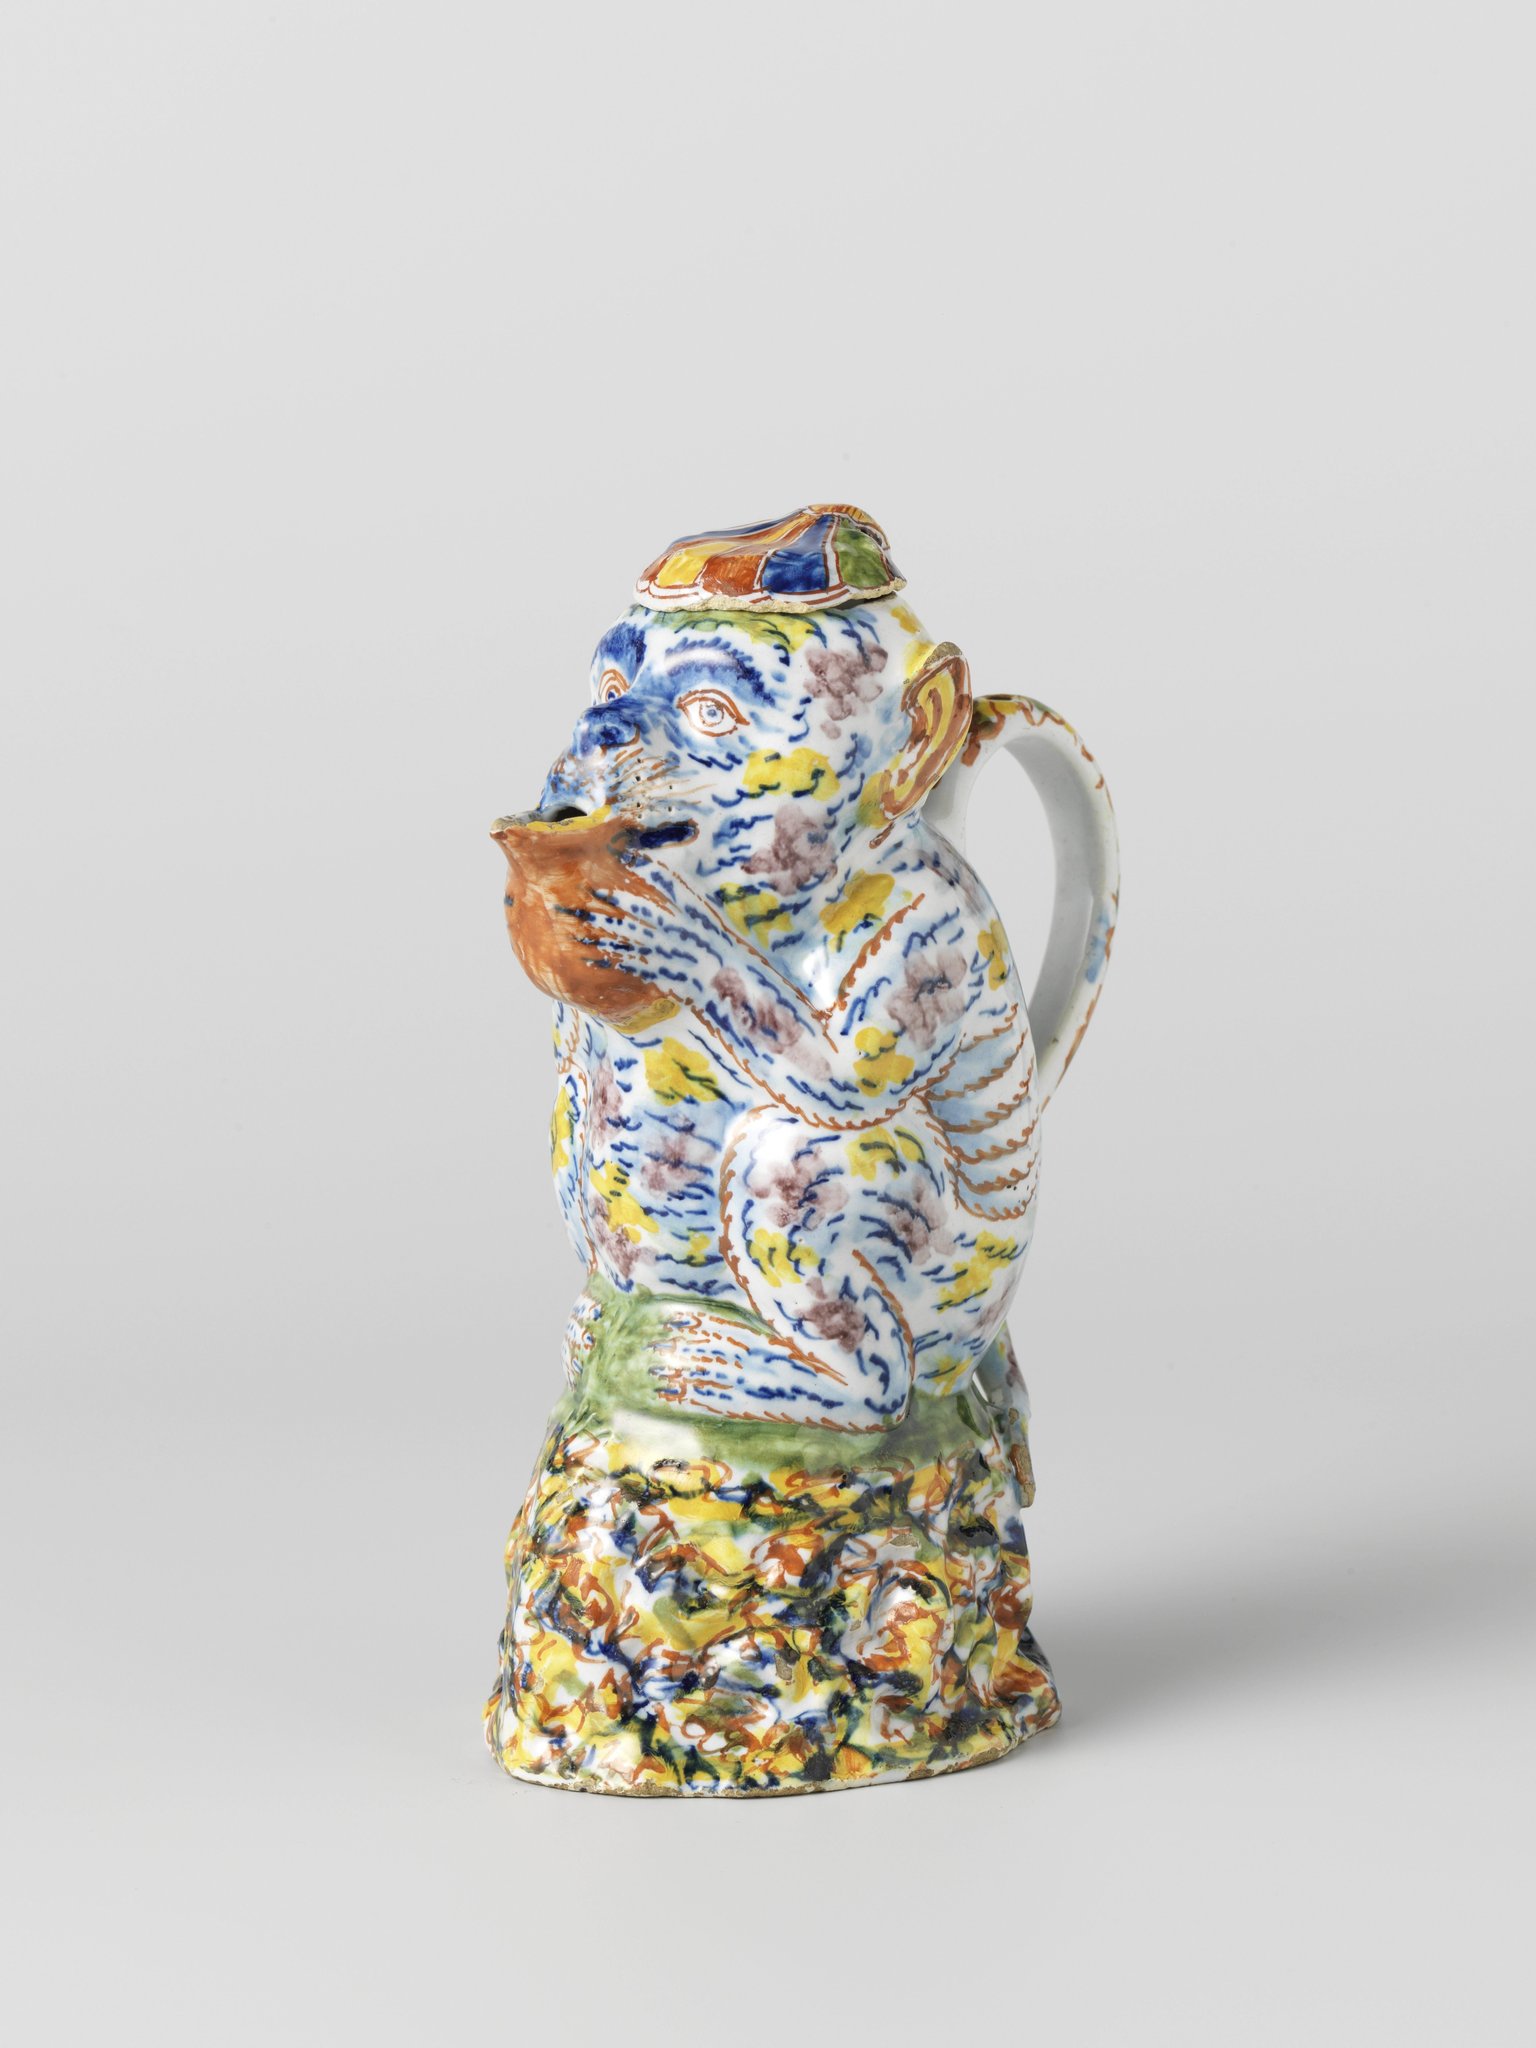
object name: milk jug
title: Deksel van melkkan in de vorm van een aap van veelkleurig beschilderde faïence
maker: Anonymous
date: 1750-1780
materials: faience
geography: delft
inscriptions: inscription: ‘A.V/ R’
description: Deksel van melkkan van faïence, in de vorm van een drinkende aap. Veelkleurig beschilderd.